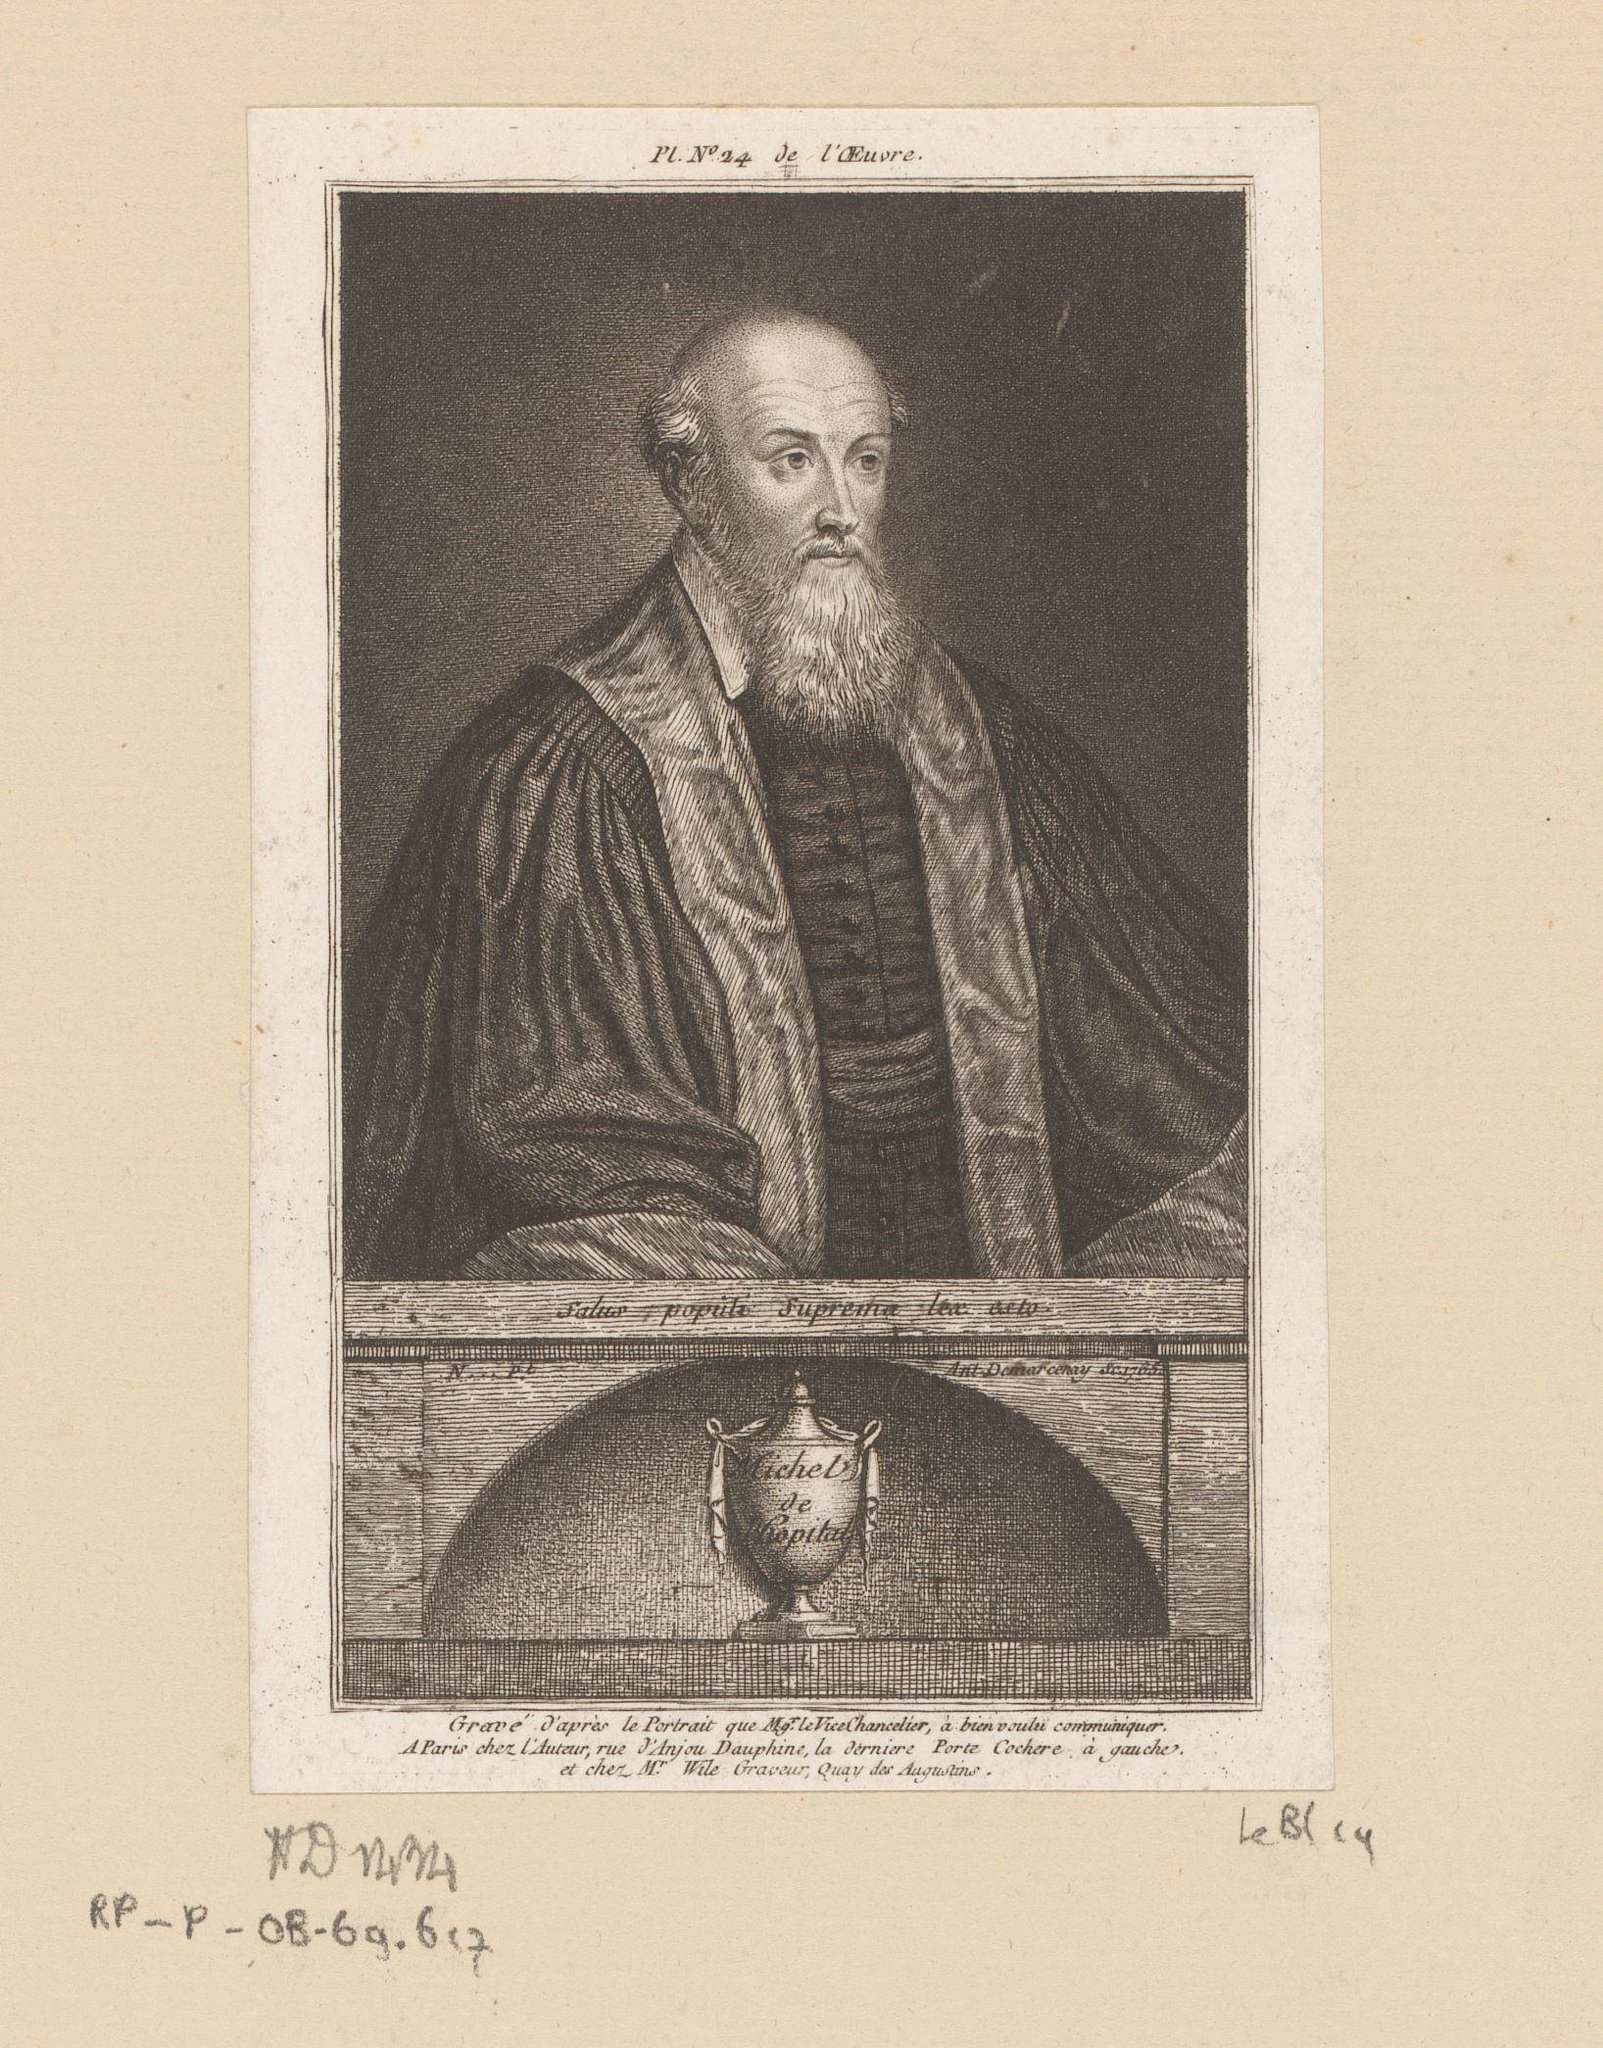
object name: print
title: Portret van Michel de L'Hospital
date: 1765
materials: paper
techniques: etching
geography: paris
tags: historical persons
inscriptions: collector's mark: Lugt 2228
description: Genummerd midden boven: Pl. No. 24 de l'Oeuvre.